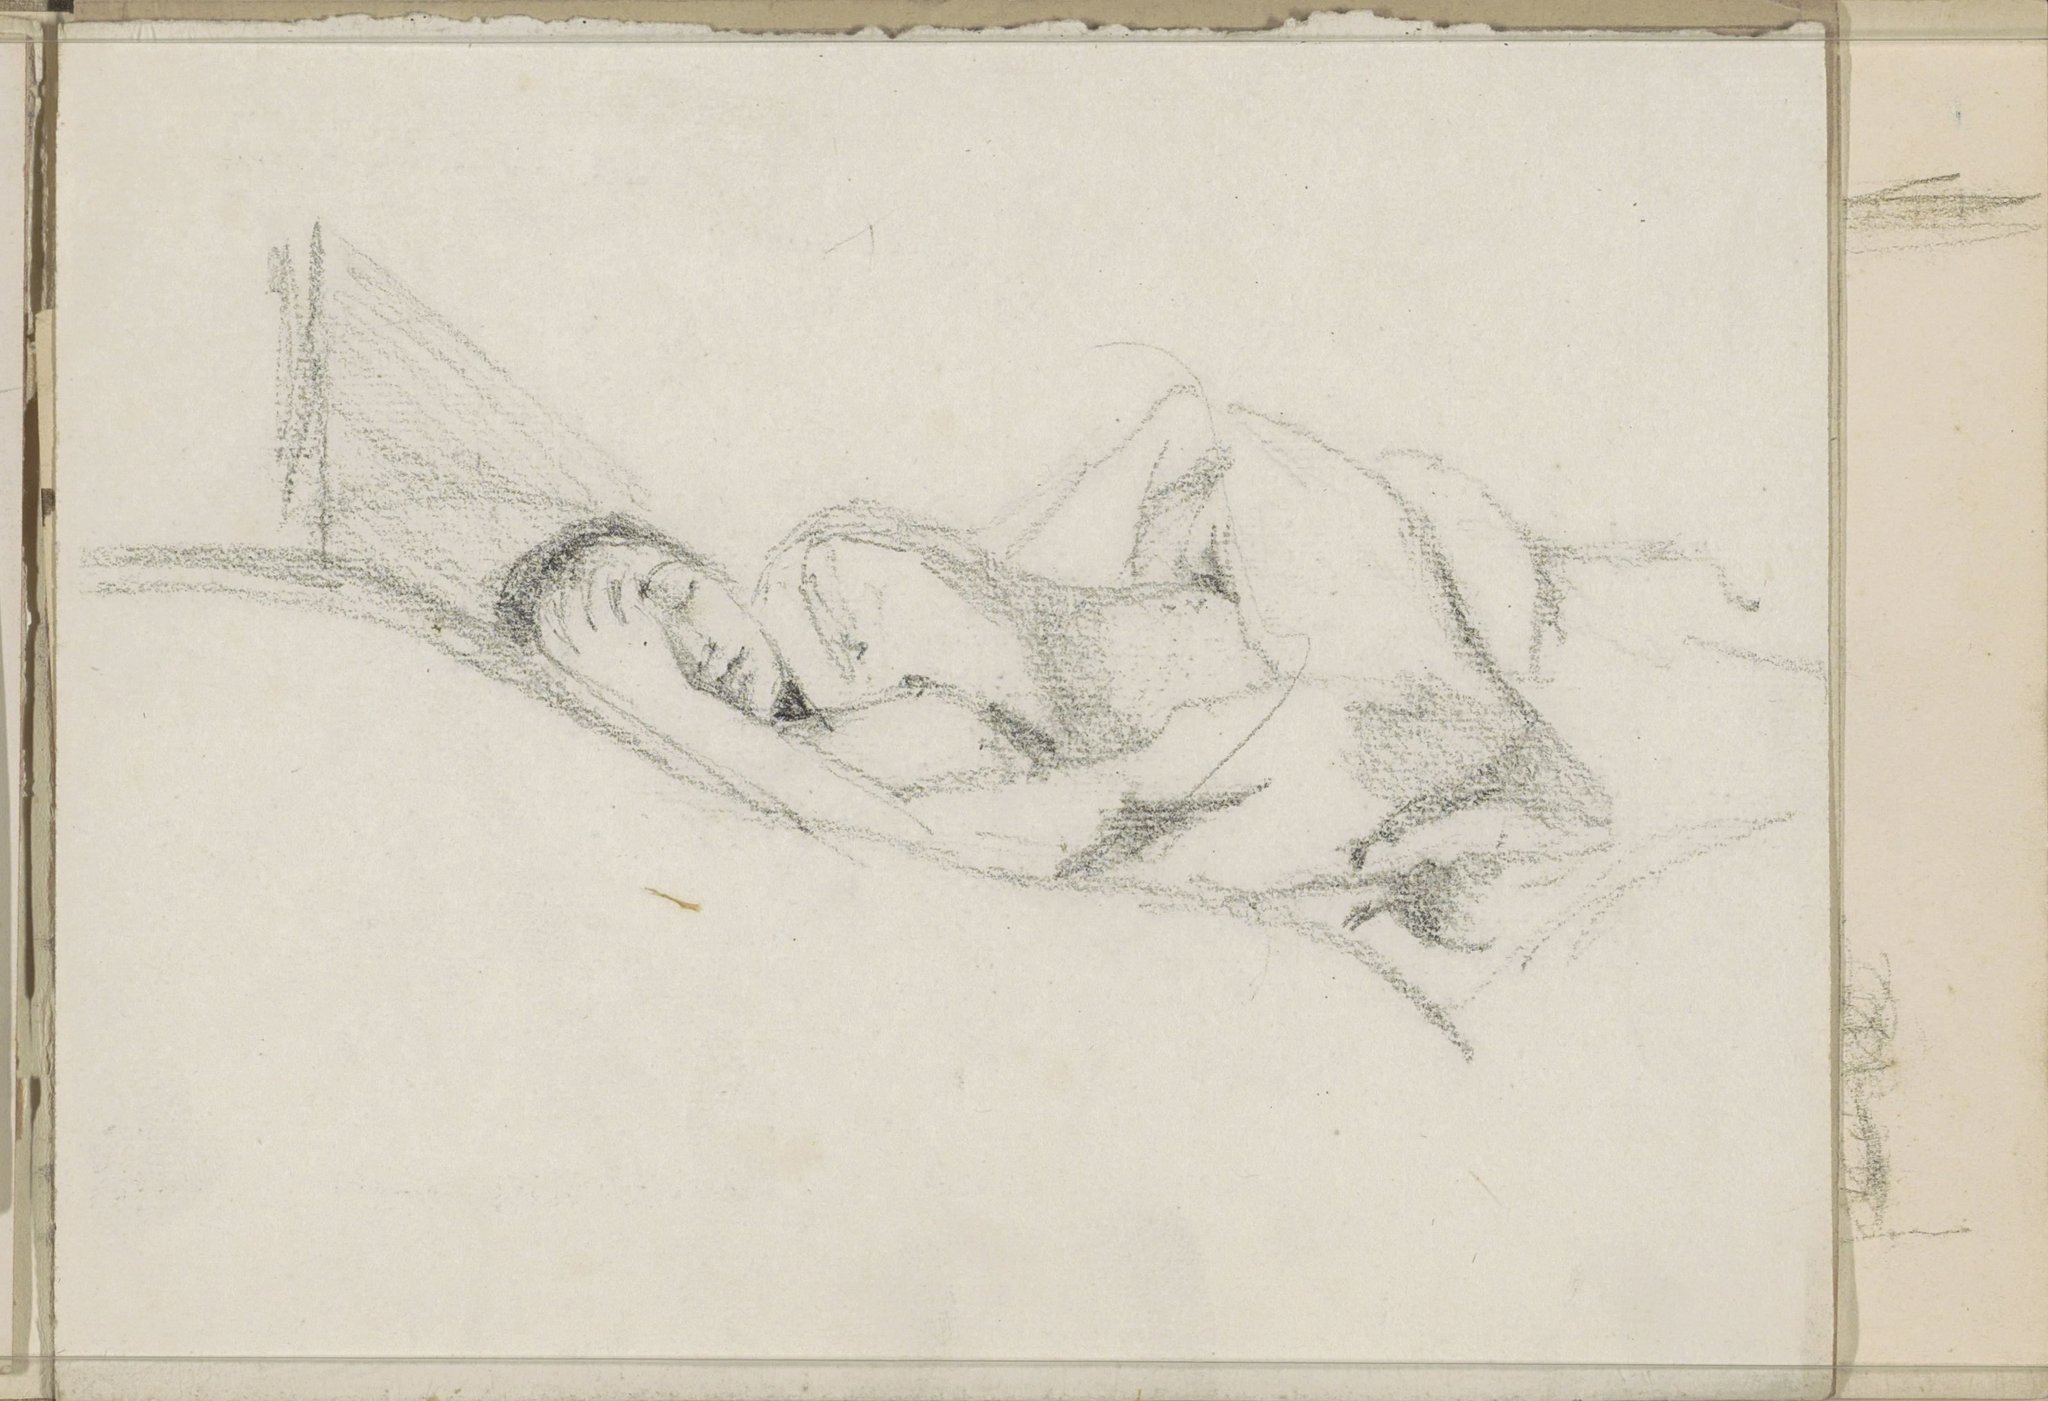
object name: sketchbook leaf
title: Vrouw liggend in bed met een hand tegen het voorhoofd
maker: a.a.l. de grammont-hubrecht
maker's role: draughtsman, painter, print maker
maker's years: 1855-1913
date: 1865-1913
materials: paper, pencil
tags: adult woman, hand towards the forehead, bed, lying figure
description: Losse schets tussen pagina 1 en 2 uit een schetsboek met 68 bladen.